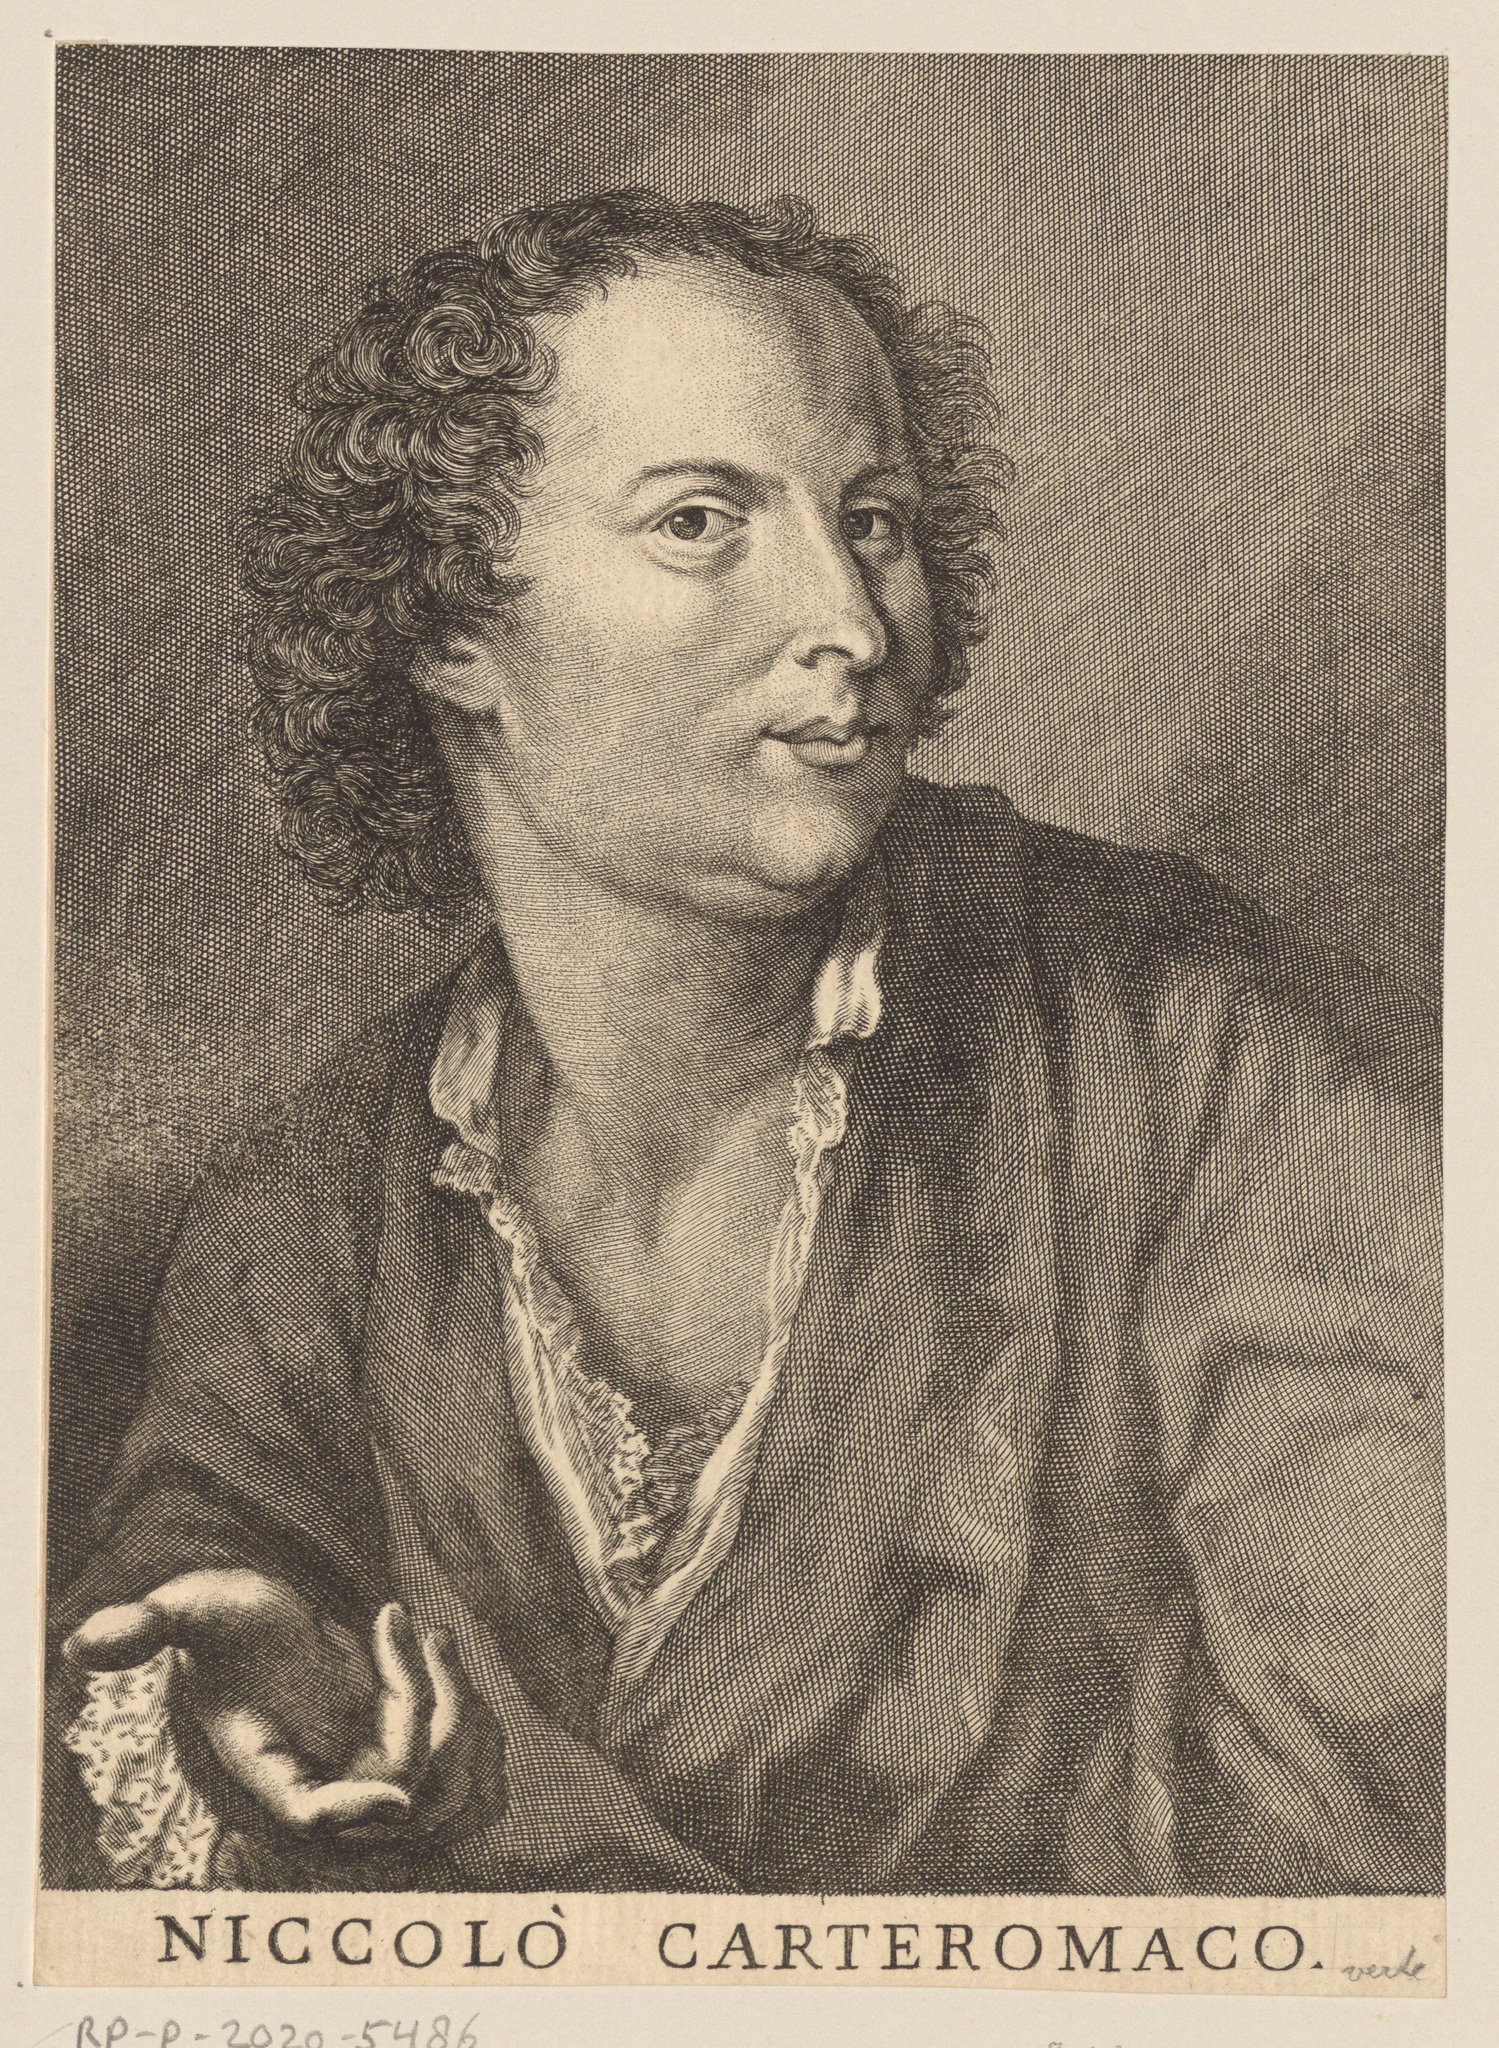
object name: print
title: Niccolò Carteromaco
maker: Anonymous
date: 1700-1750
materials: paper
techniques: engraving, etching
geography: italy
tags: historical persons, portrait of a writer